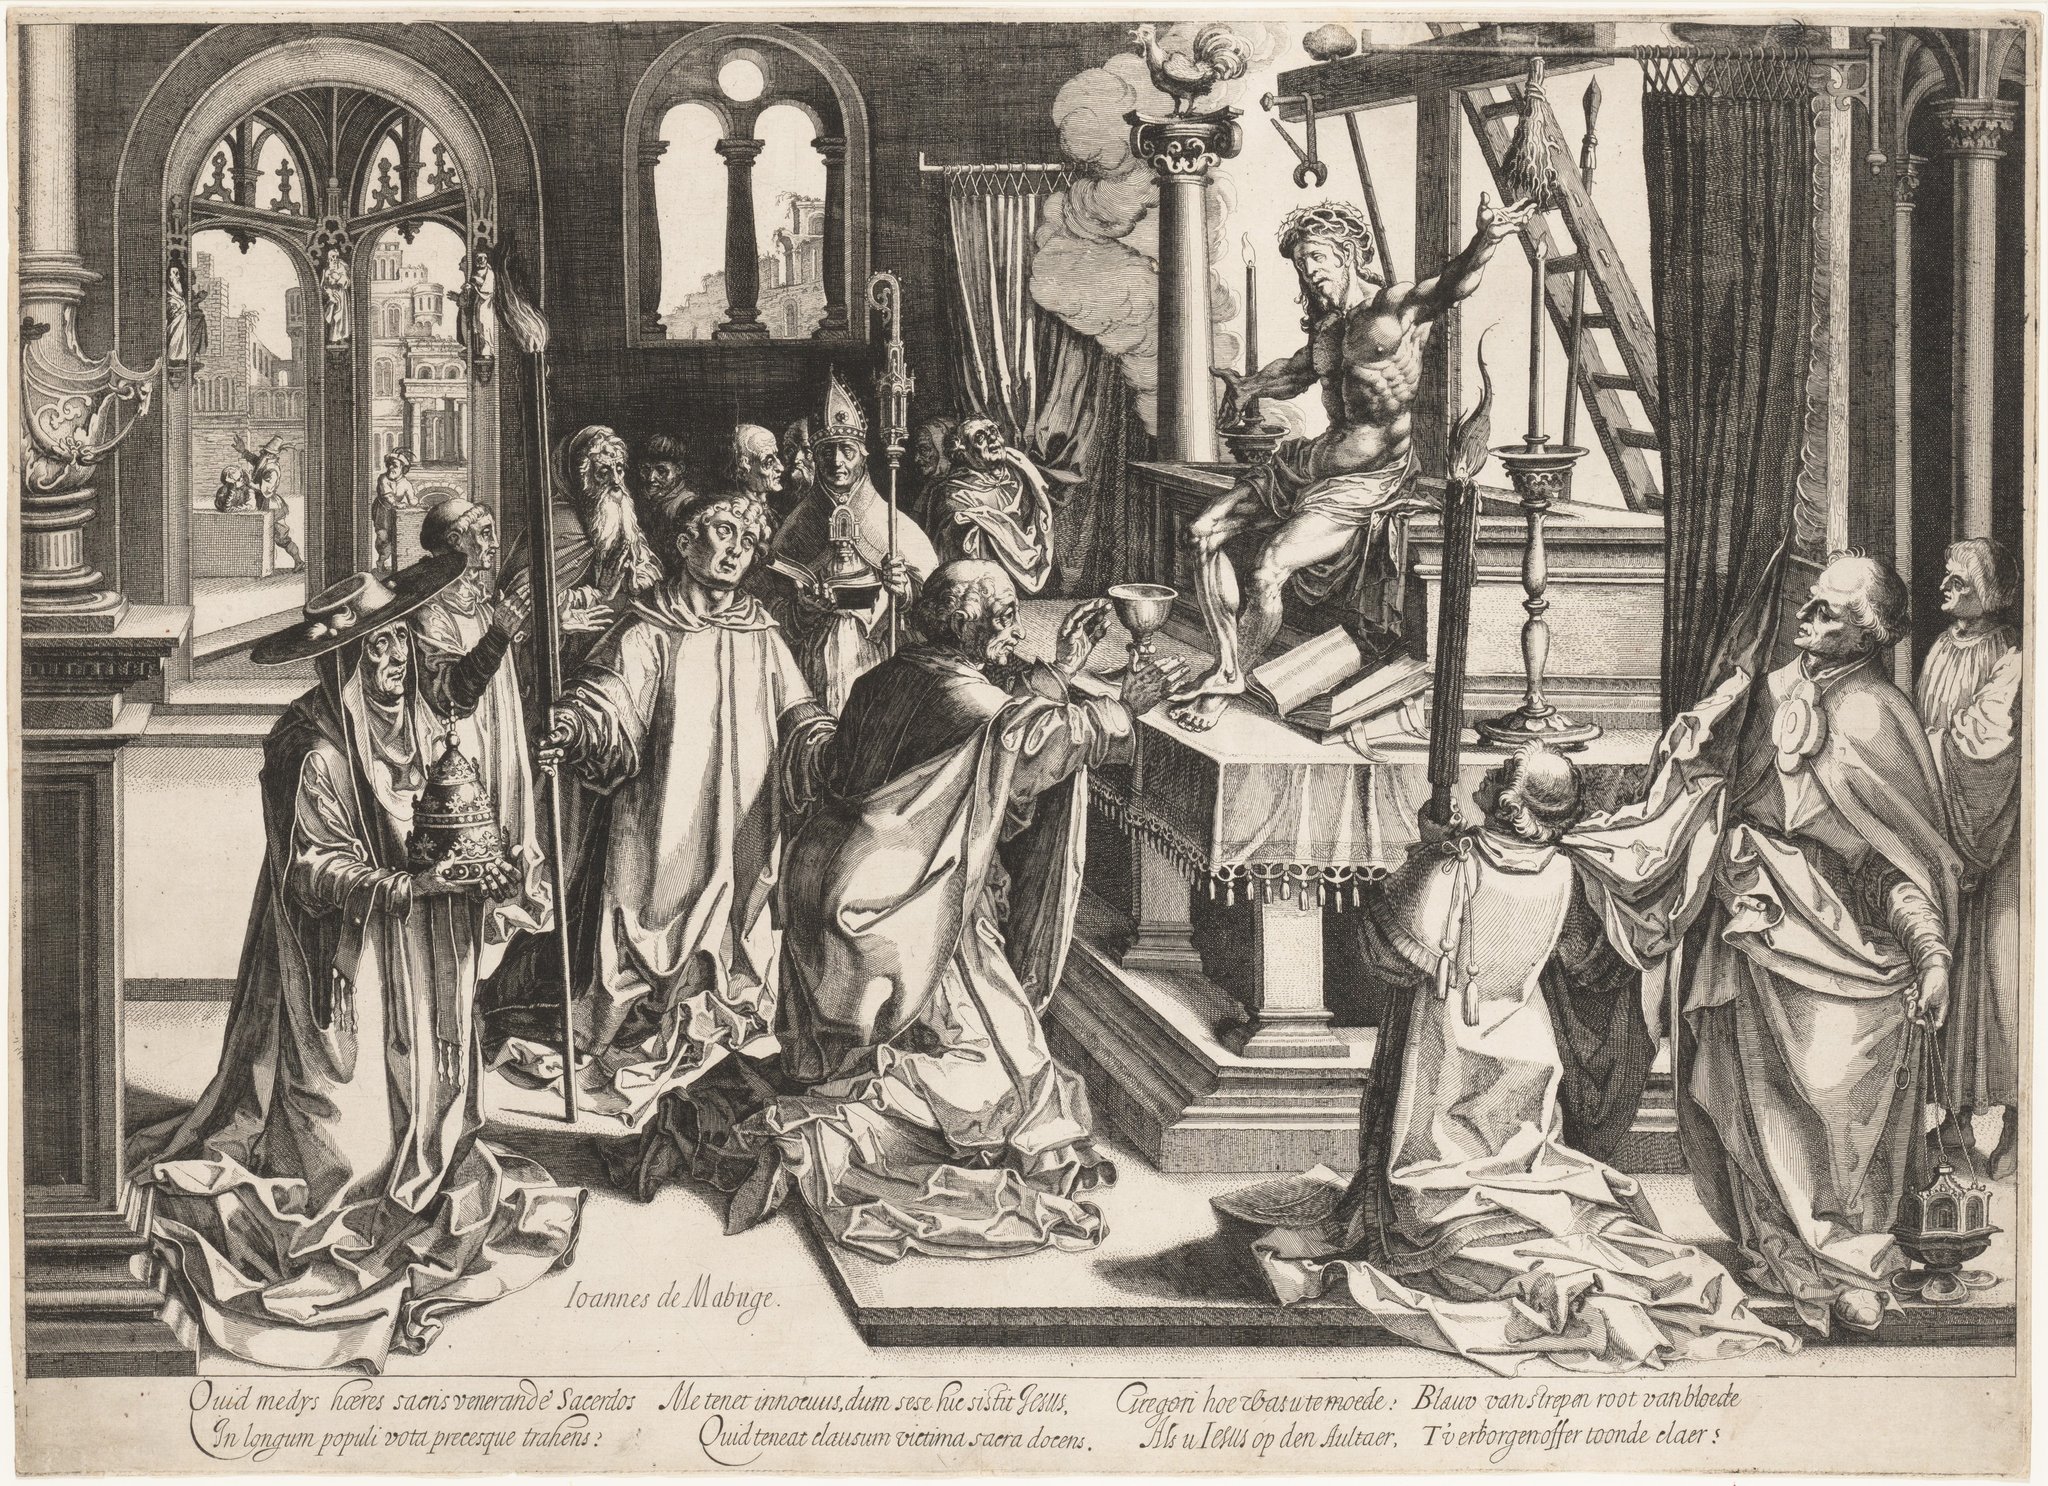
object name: print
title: Mass of St. Gregory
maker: simon wynhoutsz frisius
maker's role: artist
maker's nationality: netherlandish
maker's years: 1580-1628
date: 1610-1630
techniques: etching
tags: men,christ,saints